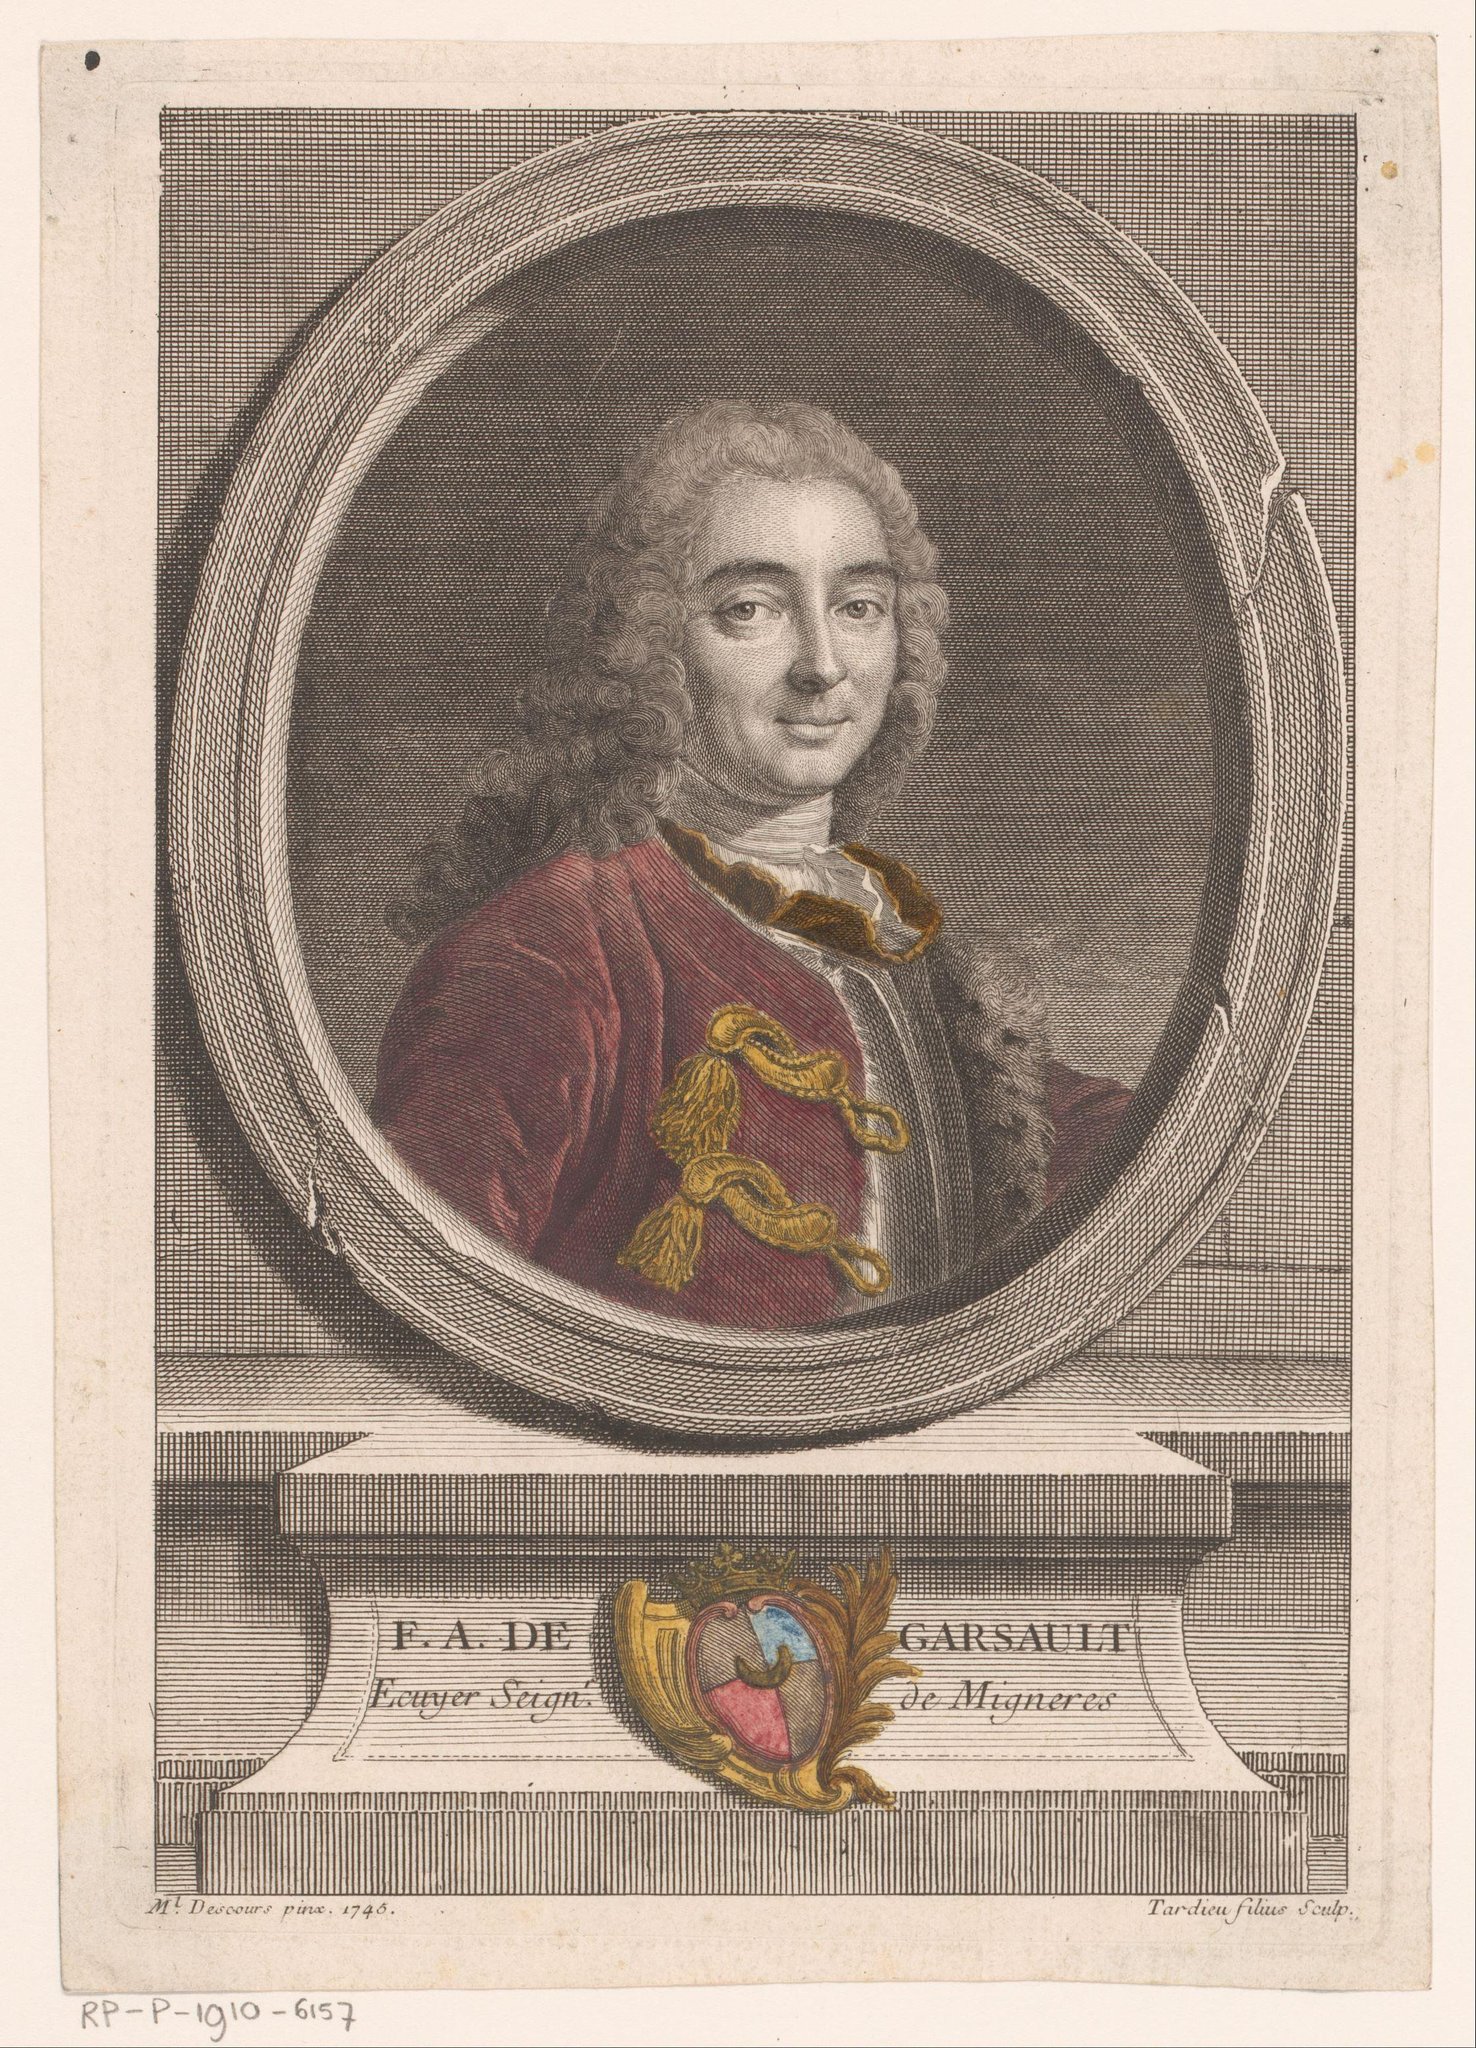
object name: book illustration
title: Portret van François Alexandre de Garsault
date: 1746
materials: paper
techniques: engraving, etching, hand coloring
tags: paris, historical persons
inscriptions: collector's mark: Lugt 2228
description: Prent als illustratie gebruikt voor een uitgave van het boek: Garsault, François Alexandre. Le noveau parfait maréchal (...), 1746.